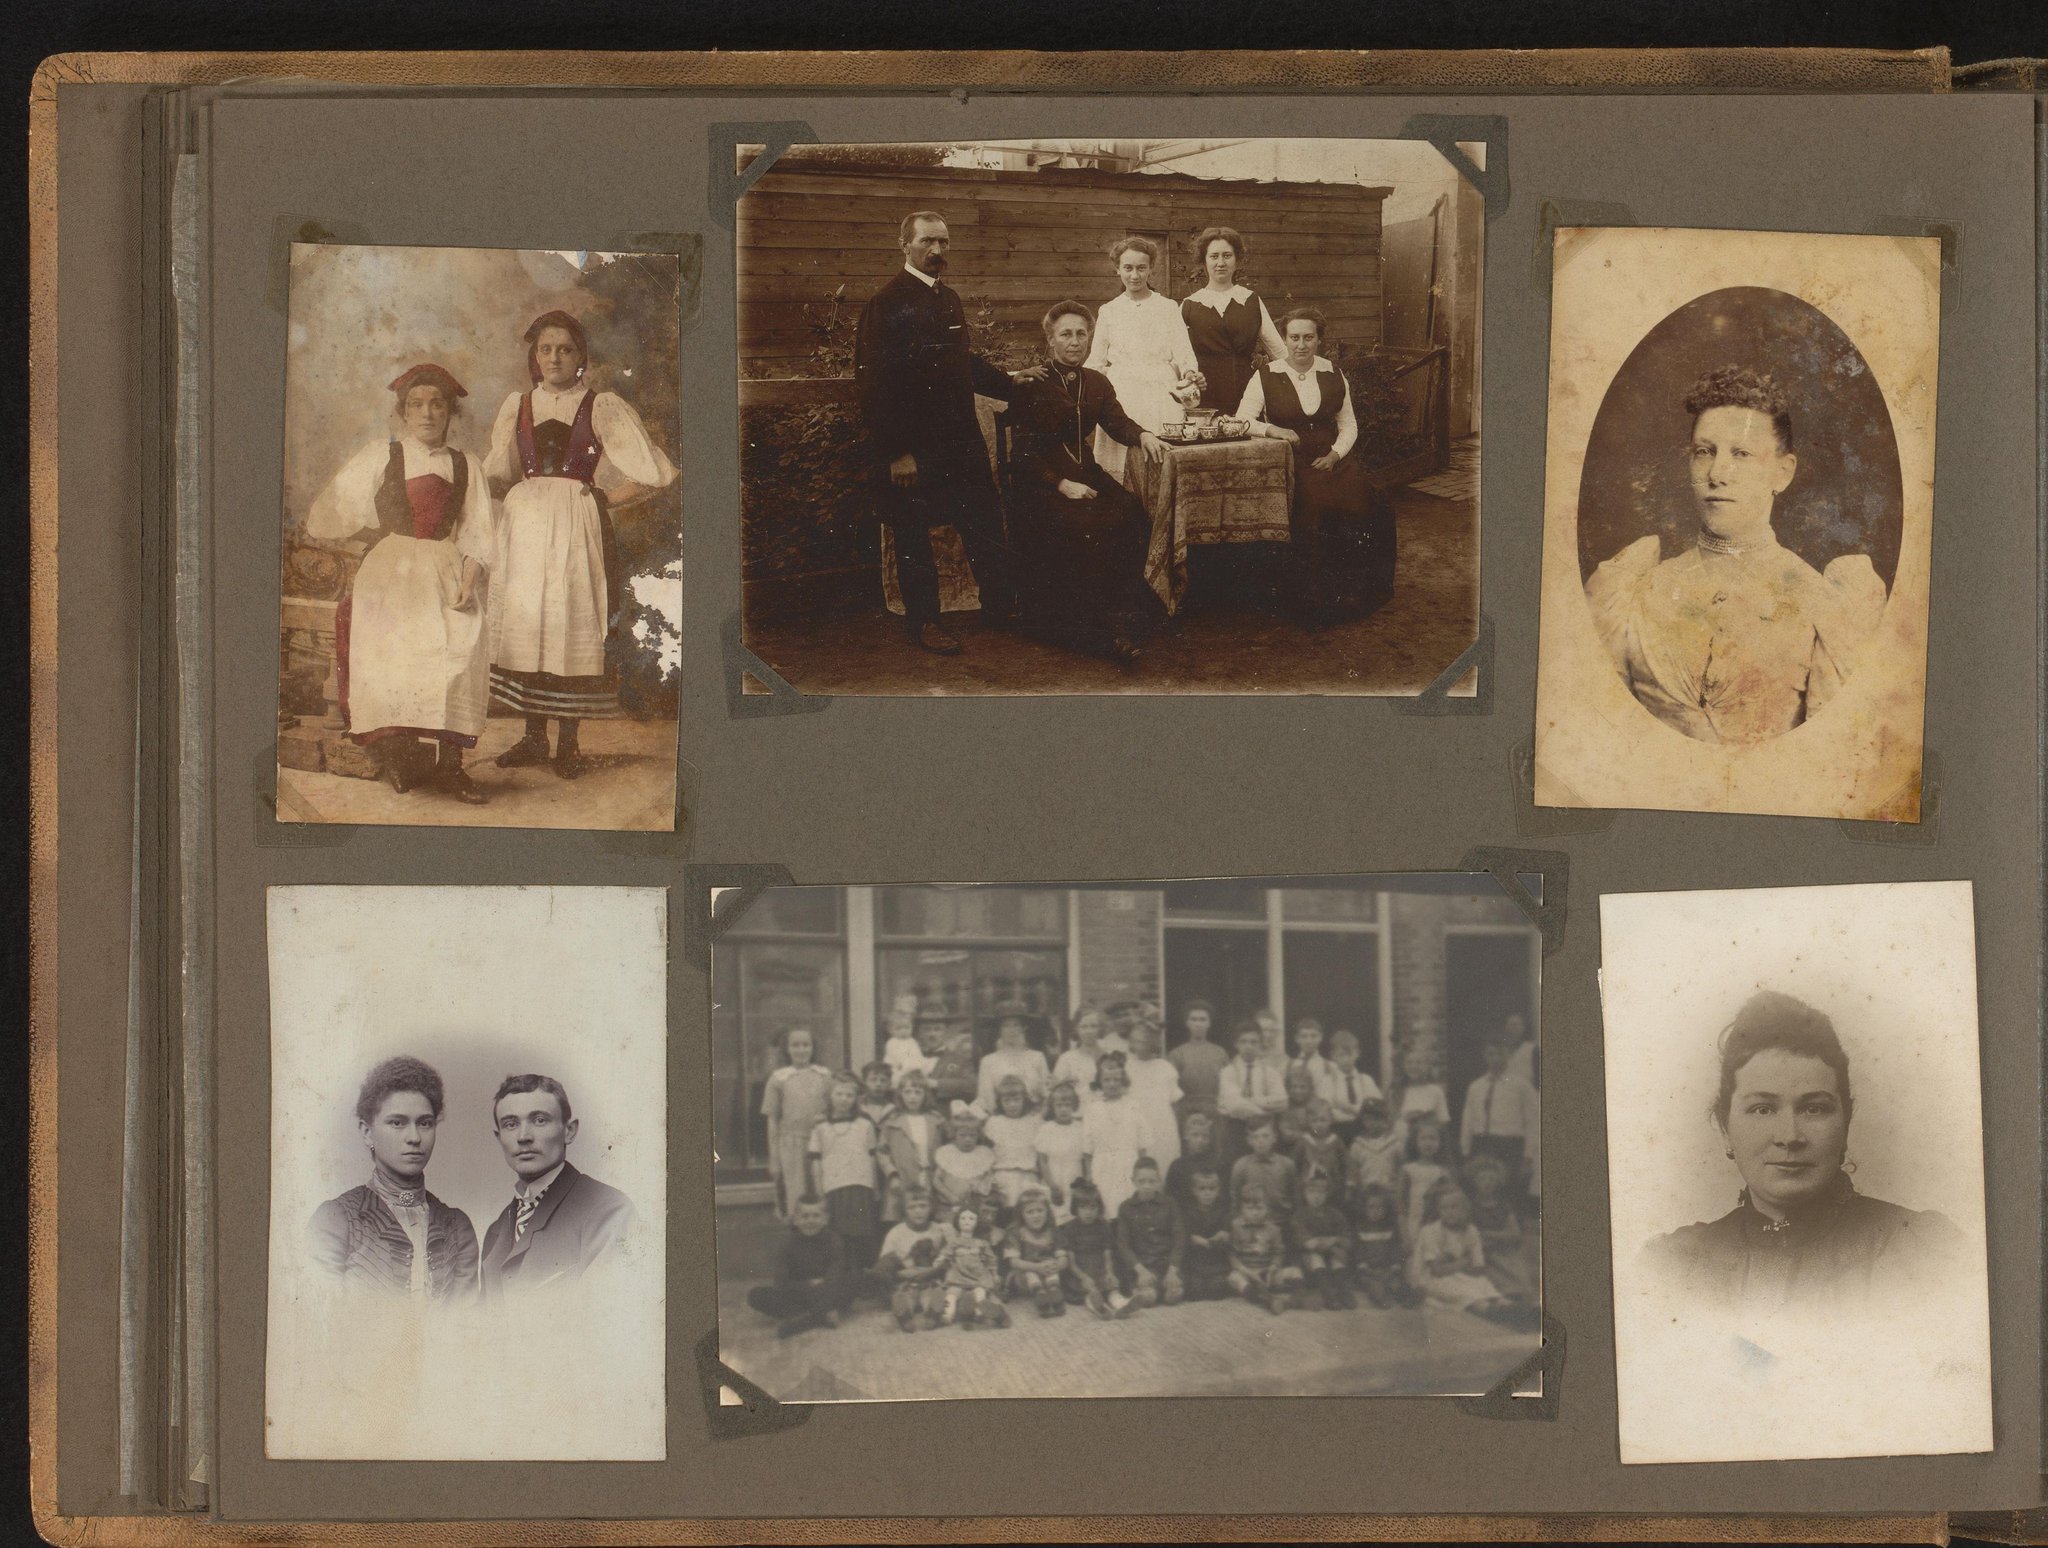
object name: photograph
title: Portretten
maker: Anonymous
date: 1900-1950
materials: photographic support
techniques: albumen print, gelatin silver print, hand coloring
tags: adult woman, adult man, child, historical persons, anonymous historical persons portrayed in a group, in a group-portrait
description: Twee portretten van vrouwen, een portret van twee vrouwen, een portret van een man en vrouw, een portret van een familie in een tuin en een groepsportret van kinderen. Deze pagina maakt deel uit van een album.